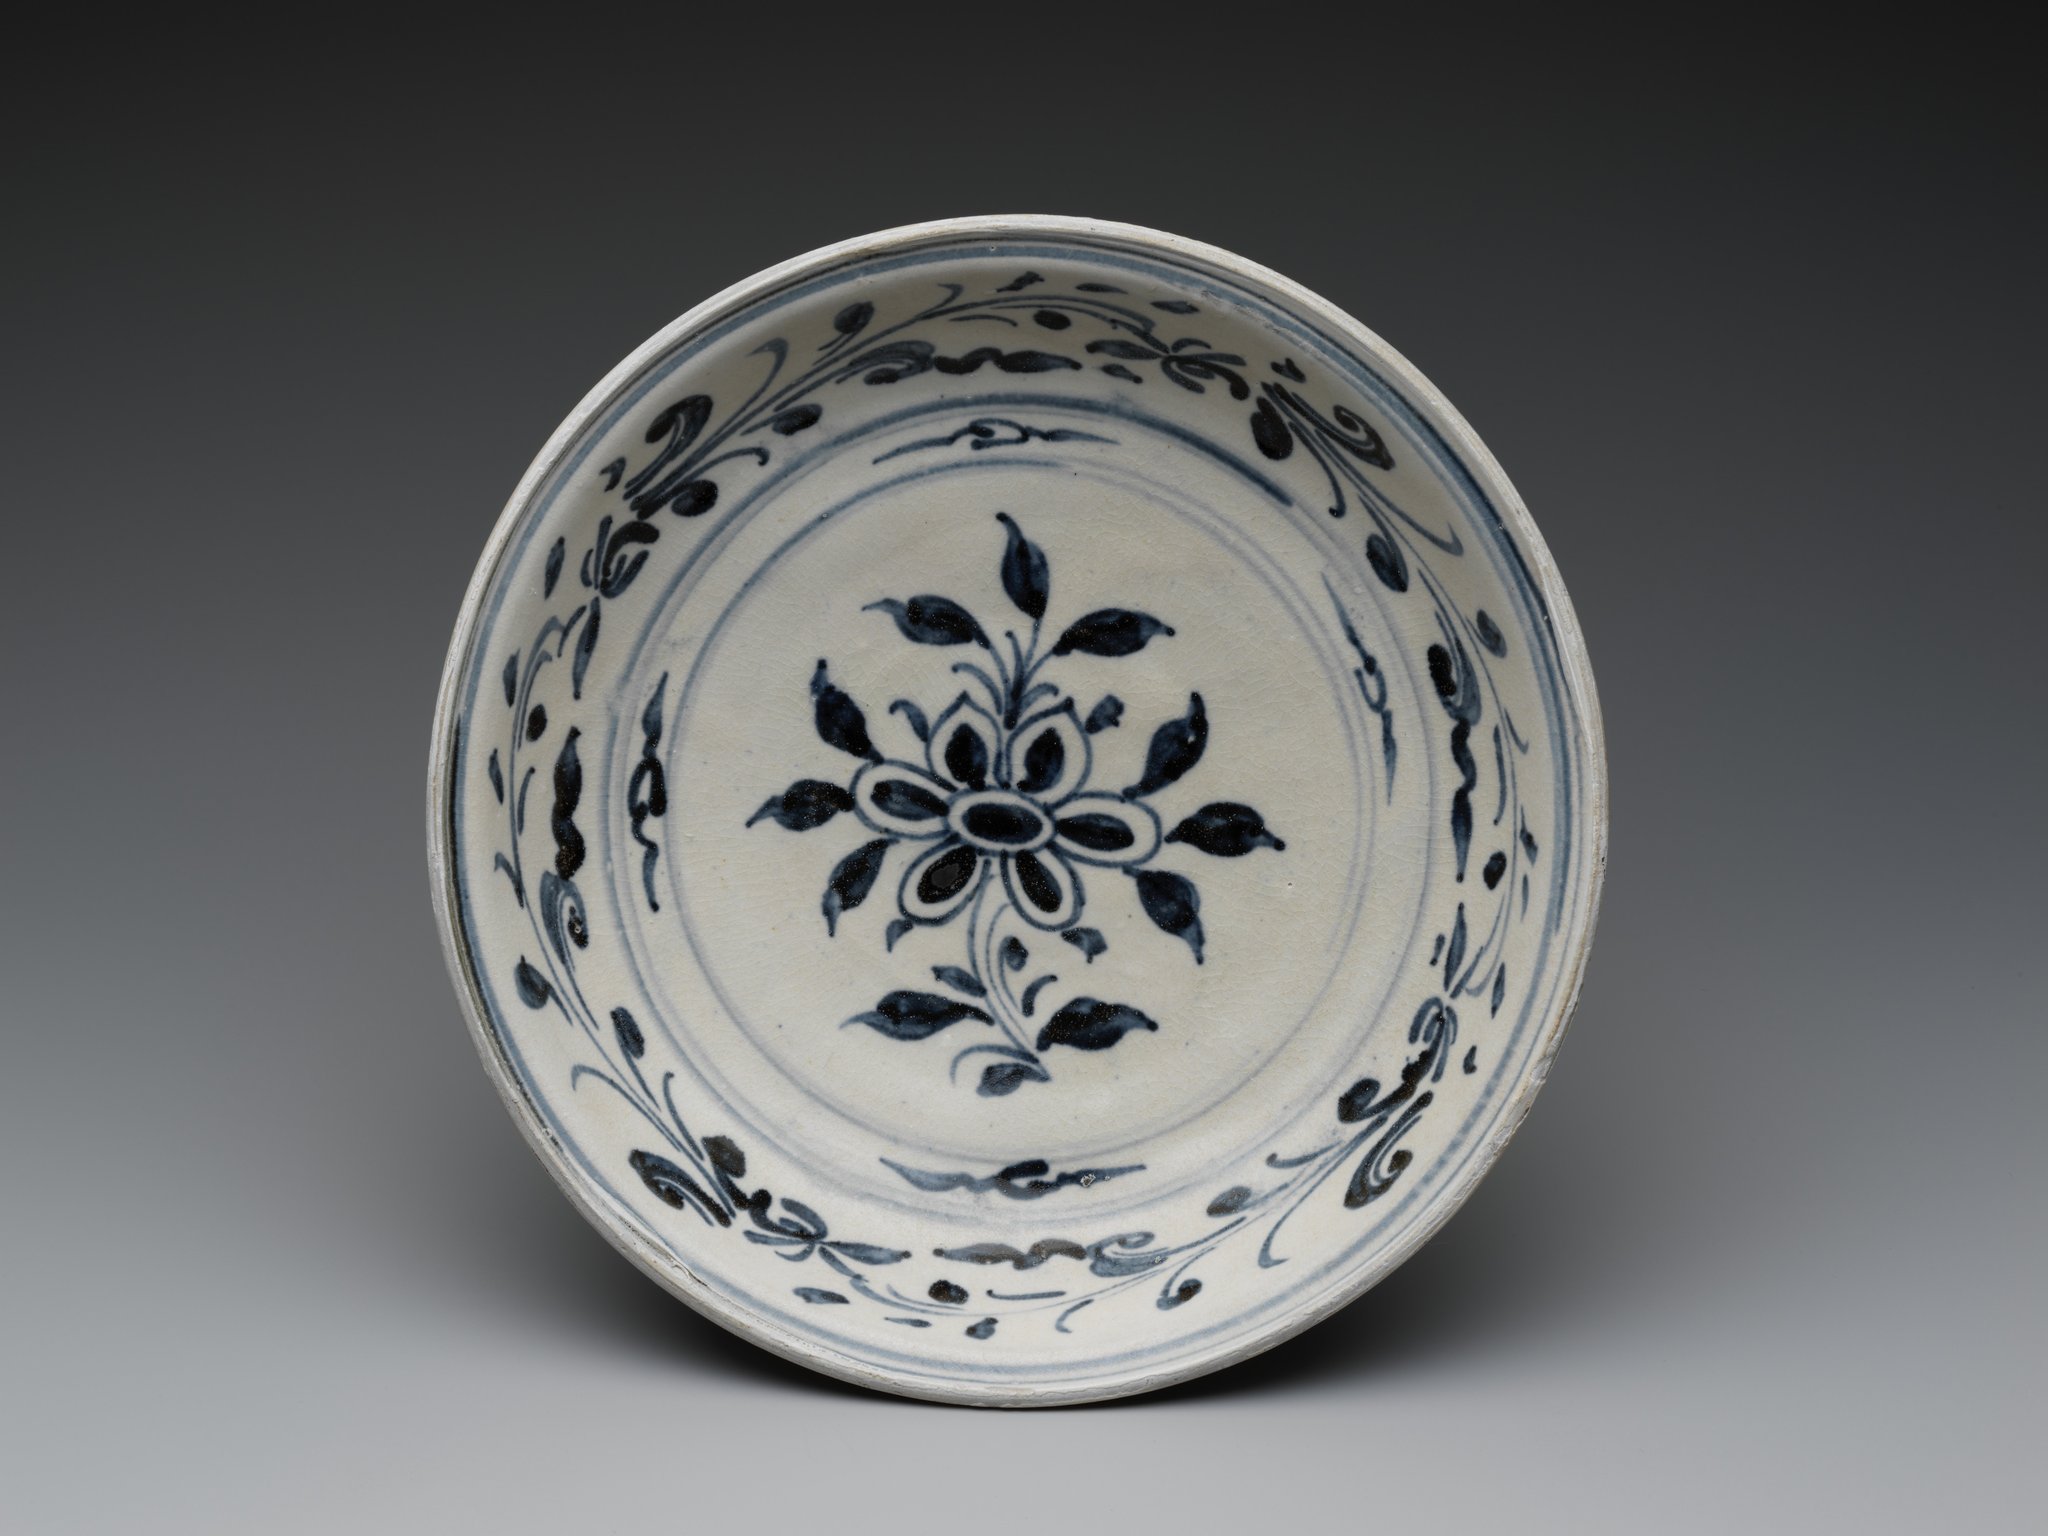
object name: dish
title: Dish with six-petalled flower design and floral scroll on cavetto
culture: vietnamese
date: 1501-1533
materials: cobalt, glaze, stoneware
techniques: painting